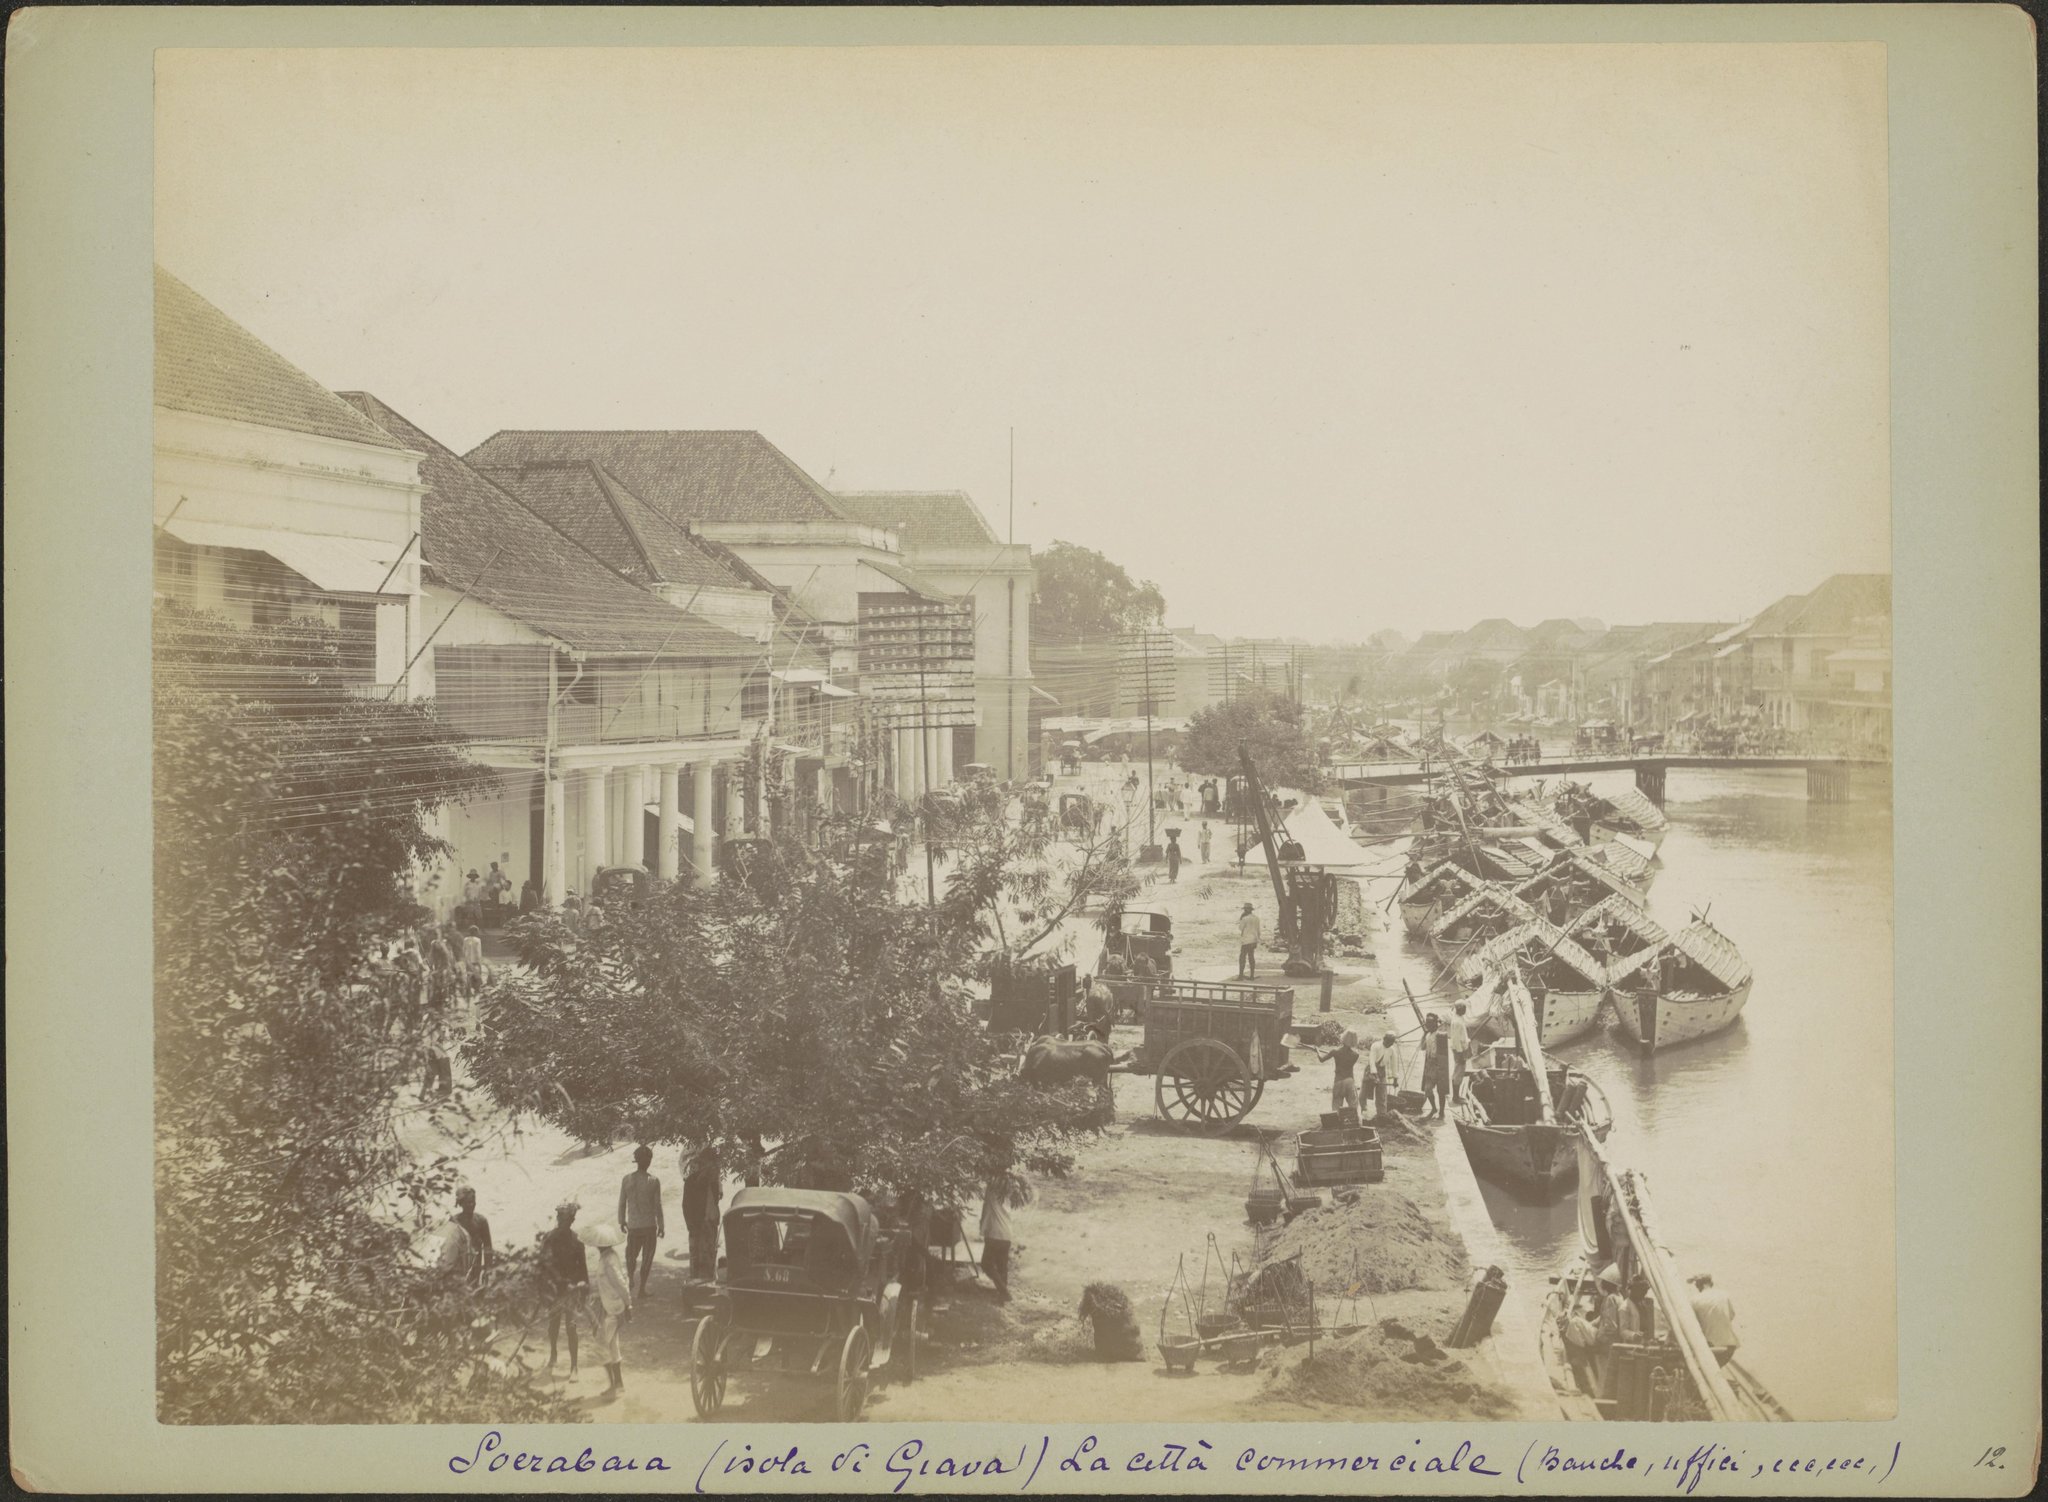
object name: album leaf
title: Gezicht op de kade bij de Roode Brug in Soerabaja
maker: Anonymous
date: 1870-1910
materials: cardboard, paper, photographic support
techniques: albumen print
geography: surabaya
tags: harbour (+ view ~ vehicle, ship, etc.), quay (+ city(-scape) with figures, staffage), bridge in city across river, canal, etc., surabaya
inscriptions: inscription: ‘Roode Brug, Soerabaia’, inscription: ‘Collezione Maria van Maanen Via Boncompagni 93 Roma’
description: Onderdeel van Reisalbum met foto's van bezienswaardigheden in Marseille, Port Said, Aden, Bombay, Colombo, Singapore en Nederlands-Indië.